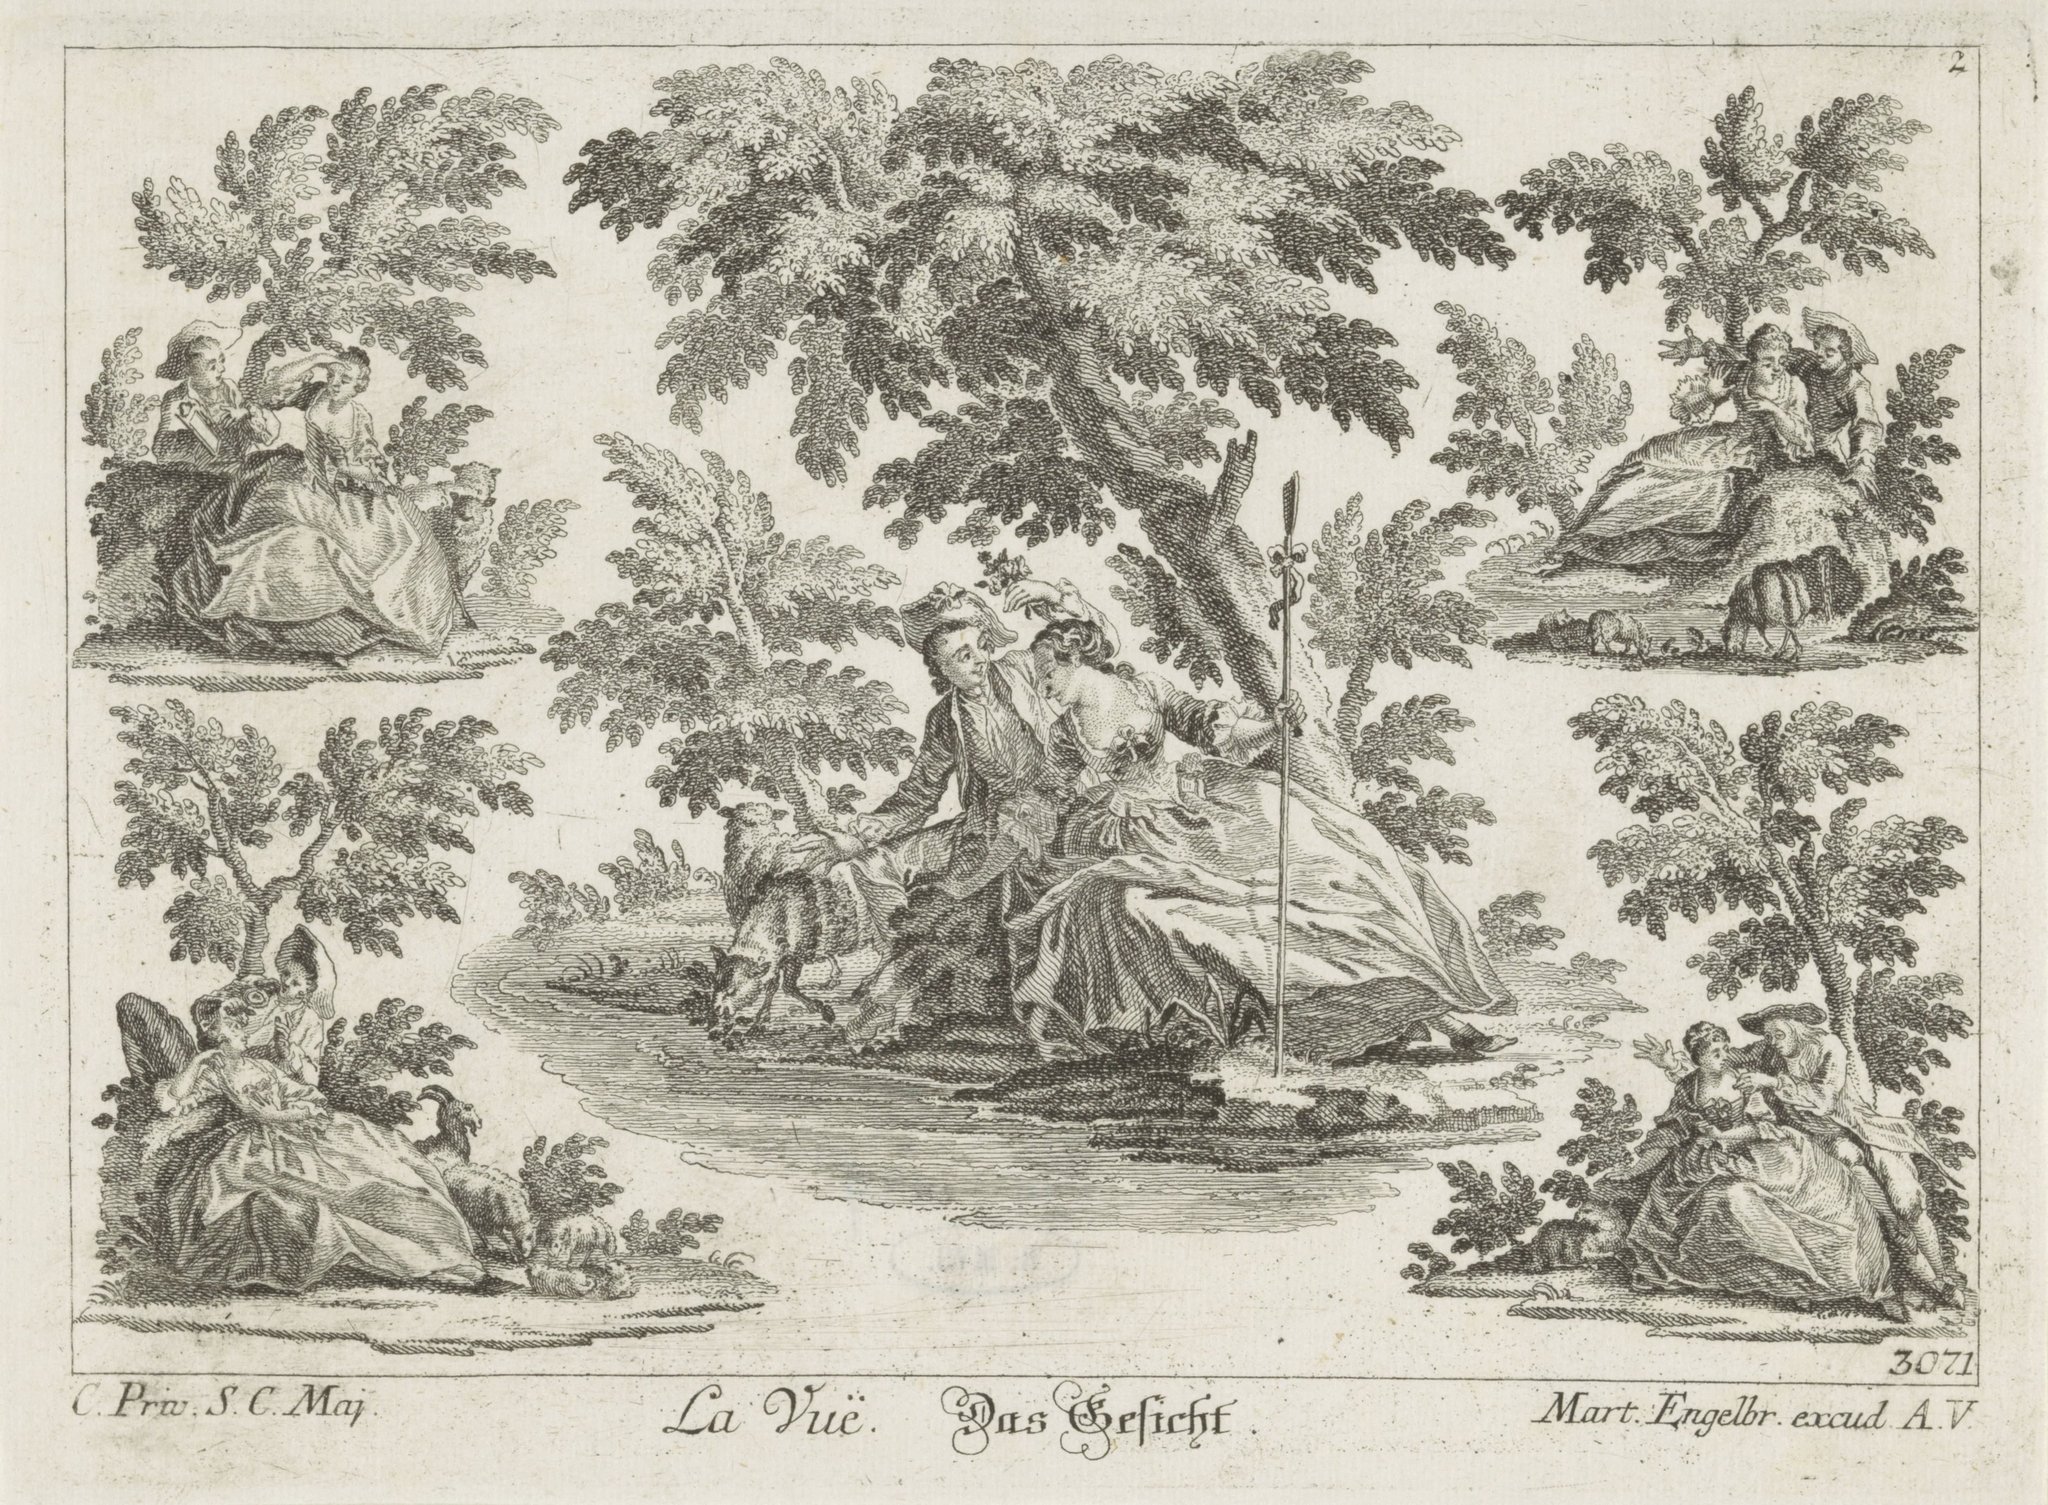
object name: ornament print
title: Het zicht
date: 1694-1756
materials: paper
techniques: etching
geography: augsburg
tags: sight, looking (one of the five senses) (+ two persons), landscapes (+ landscape with figures, staffage), pastorals, arcadian scenes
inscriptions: collector's mark: Lugt 2228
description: Vijf pastorale scènes van twee personen, het zicht betreffend. Prentnummer 3071.